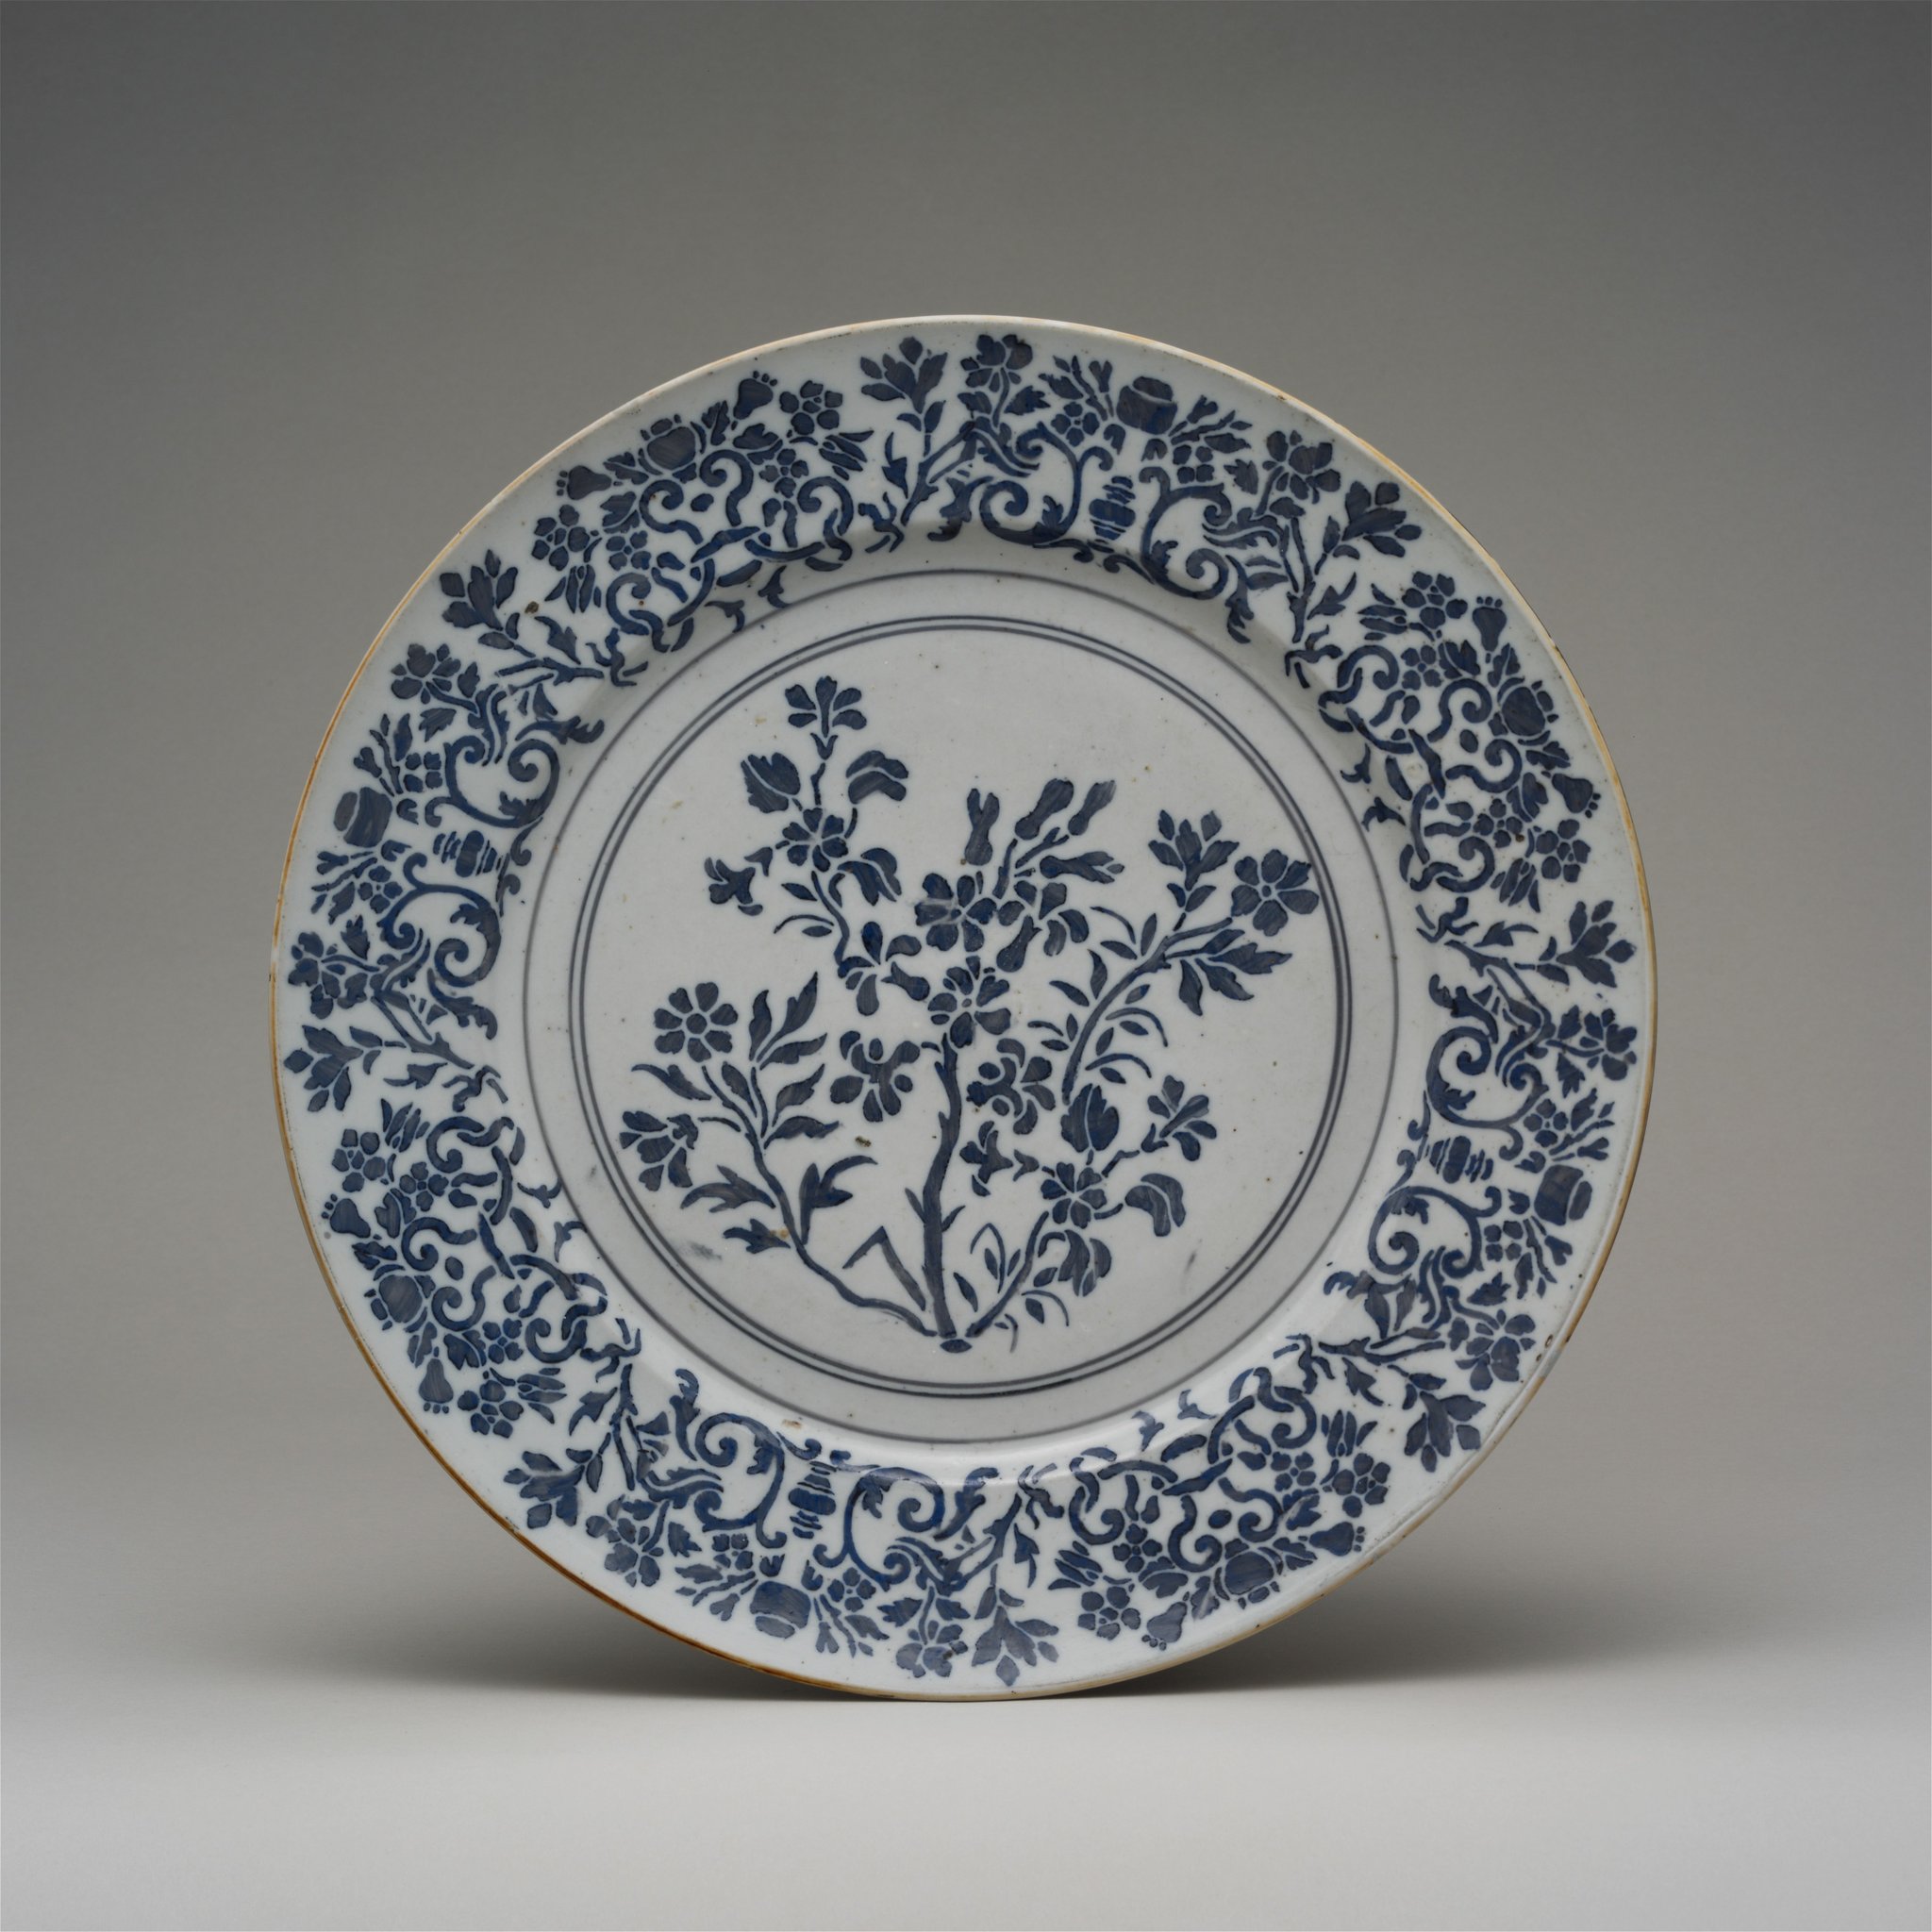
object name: dish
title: Dish with stenciled decoration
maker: doccia porcelain manufactory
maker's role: manufactory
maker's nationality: italian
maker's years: 1737-1896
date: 1745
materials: cobalt, glaze, hard paste porcelain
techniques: painting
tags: flowers,plants